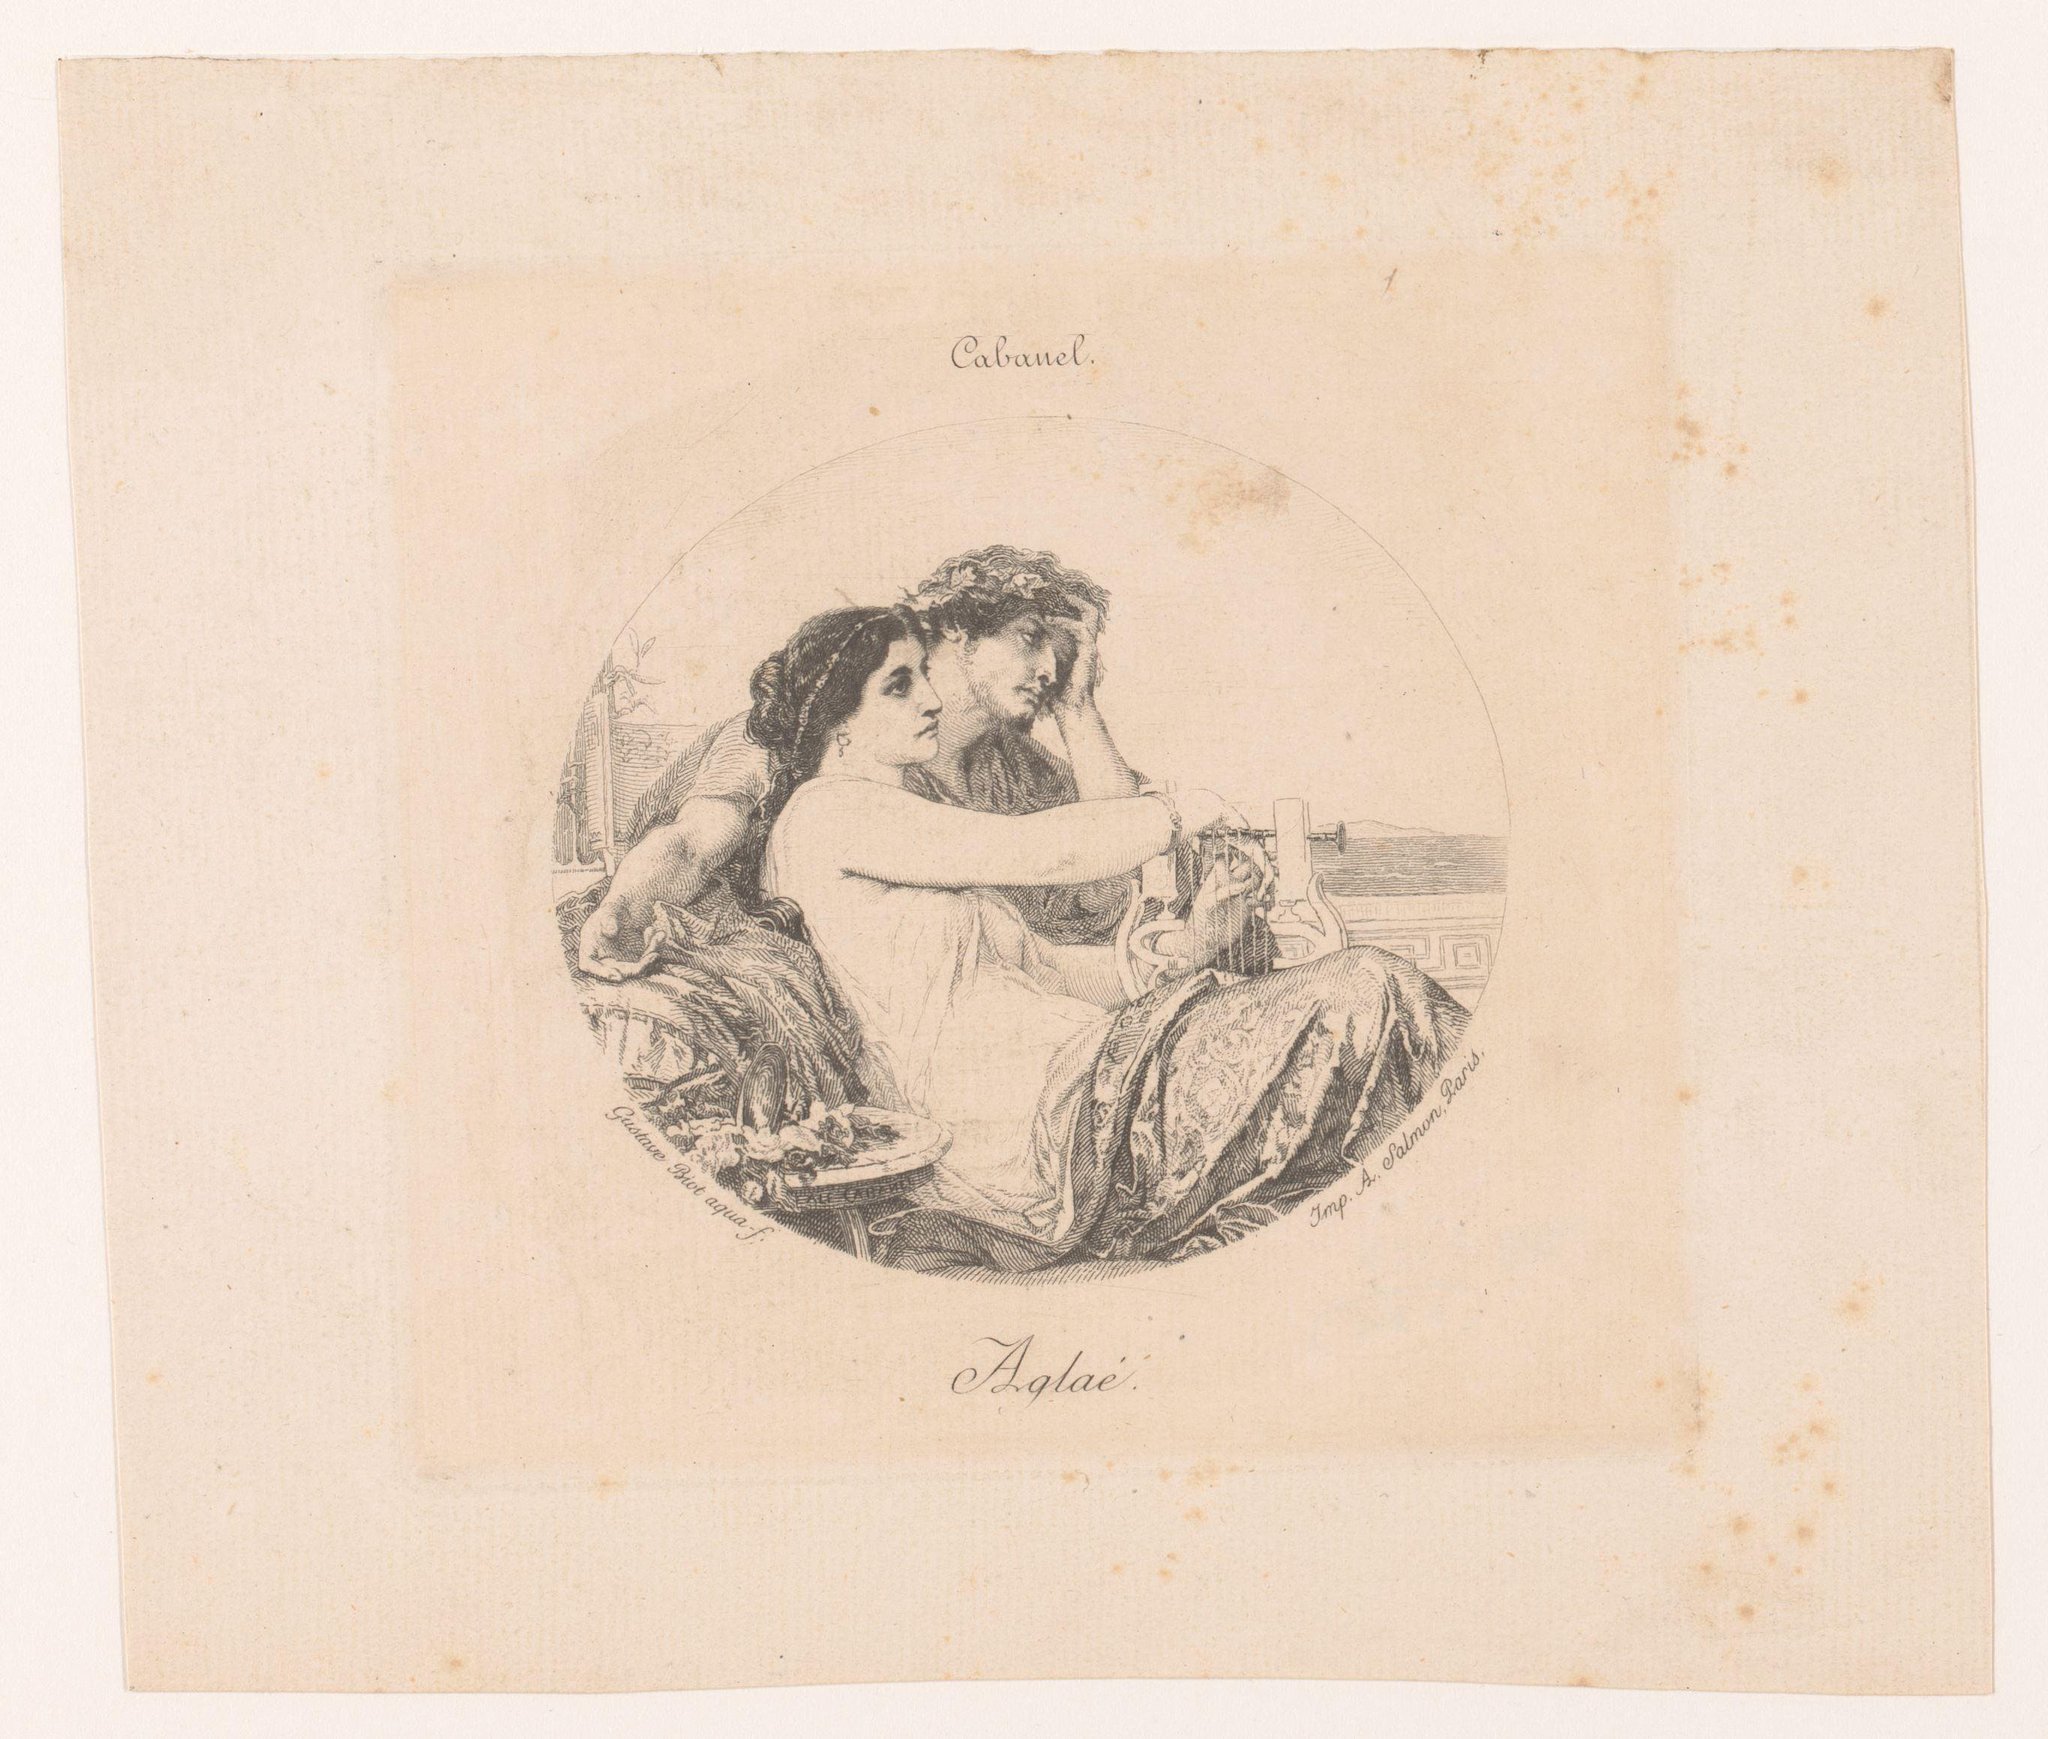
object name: print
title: Aglaé en Bonifatius van Tarsus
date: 1843-1905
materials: paper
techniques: etching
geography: paris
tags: couple of lovers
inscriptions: collector's mark: Lugt 2228